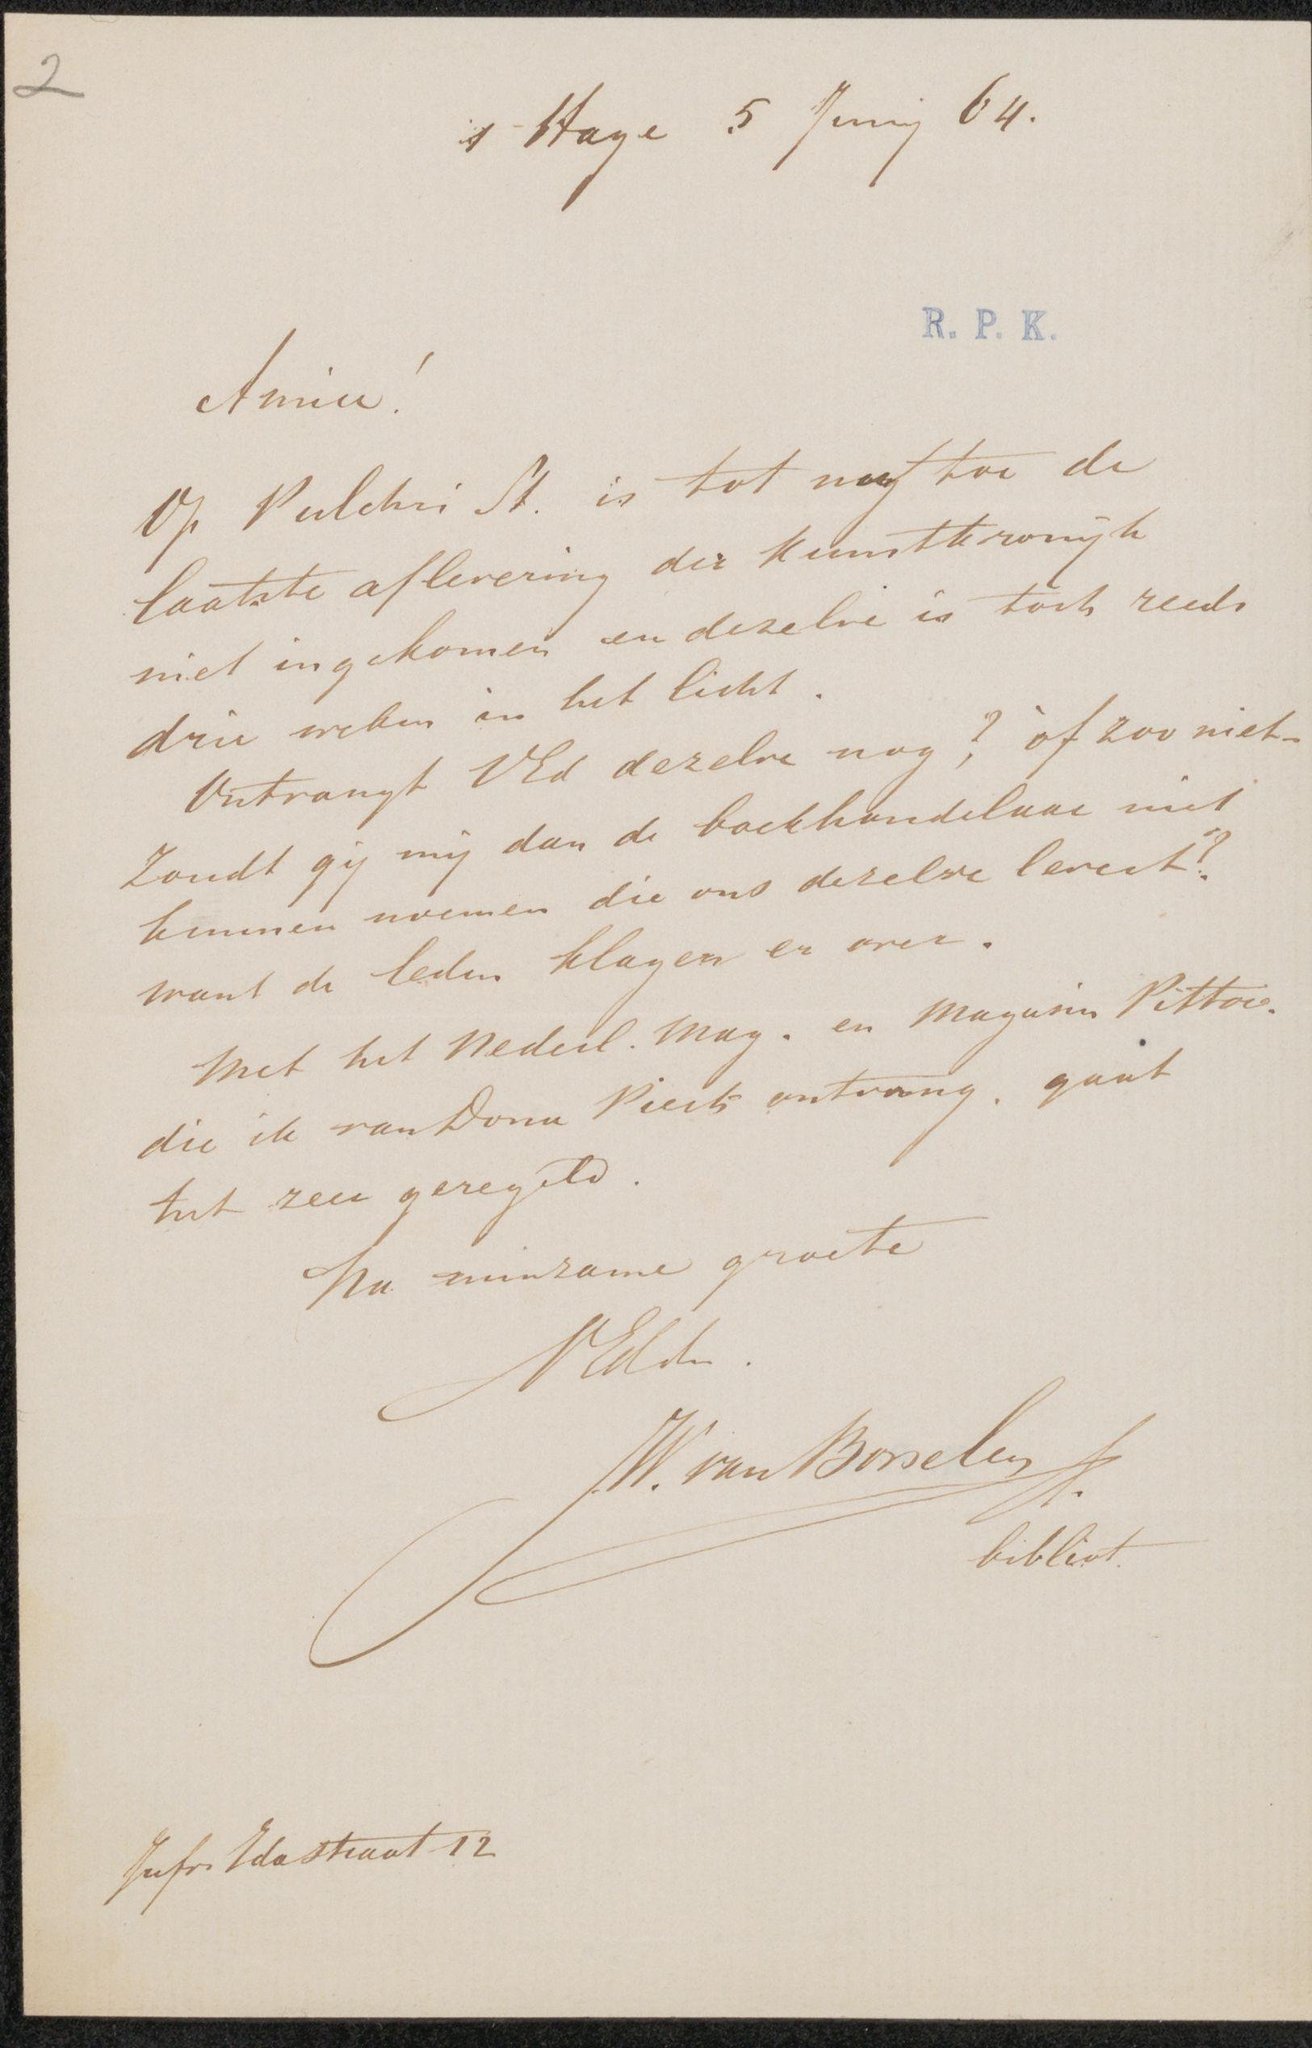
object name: letter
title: Brief aan onbekend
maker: jan willem van borselen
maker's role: draughtsman, print maker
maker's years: 1825-1892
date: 1864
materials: ink, paper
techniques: pen, writing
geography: the hague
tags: publisher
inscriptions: collector's mark: Lugt 2233